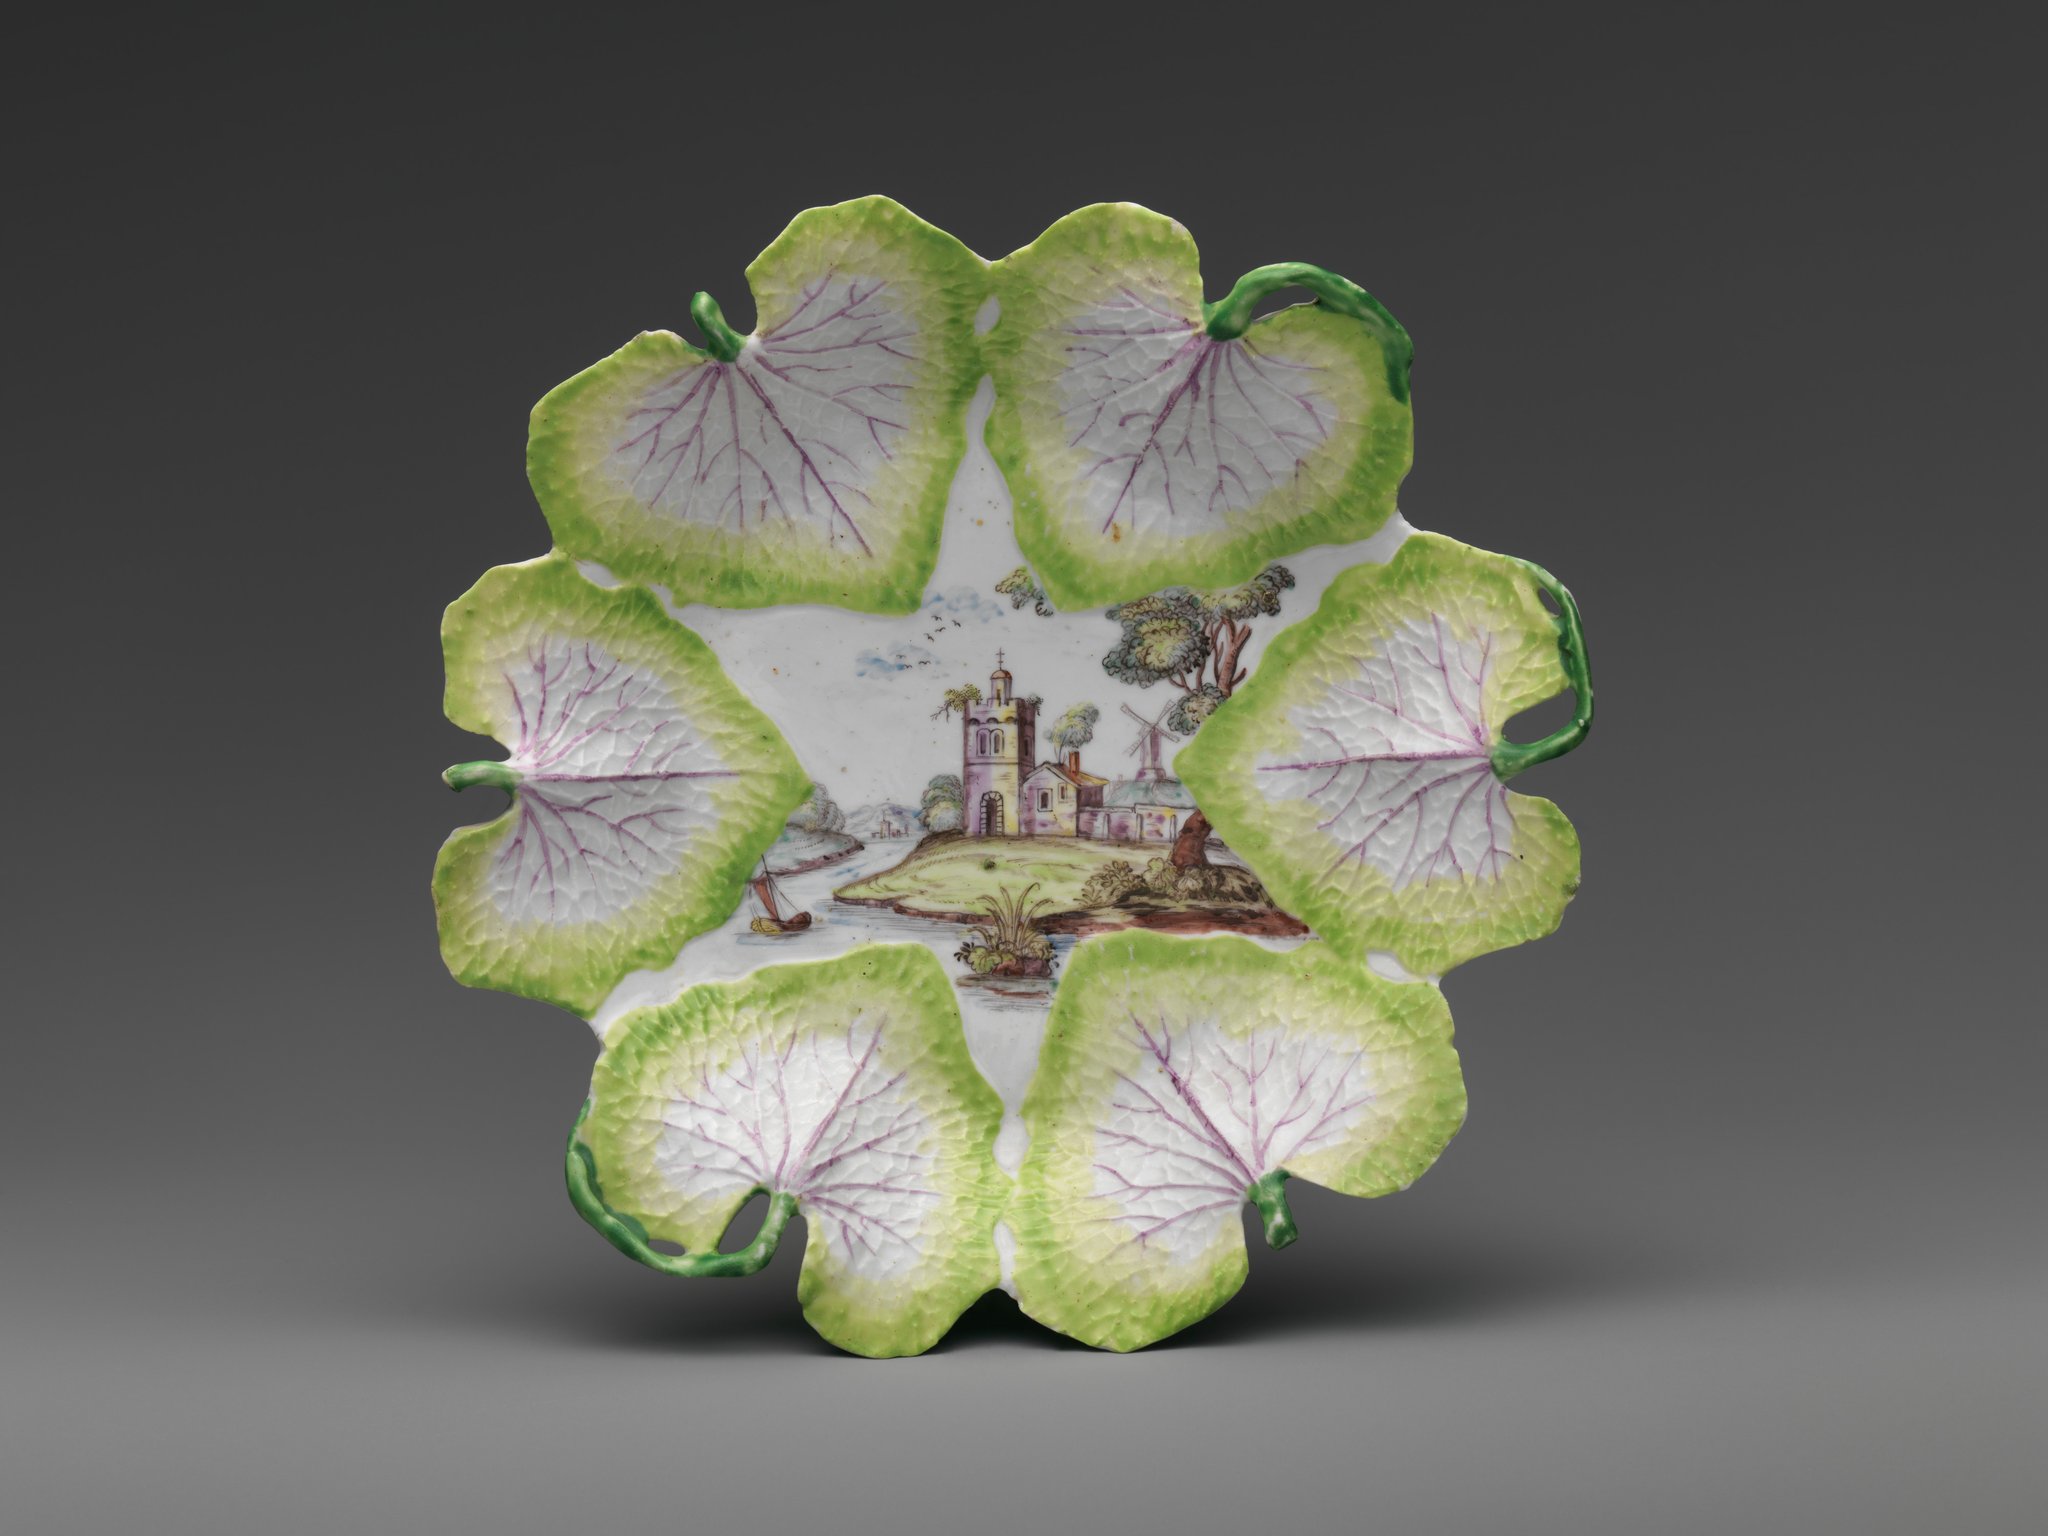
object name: dish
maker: longton hall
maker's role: factory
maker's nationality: british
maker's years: 1744-1760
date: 1749-1760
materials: enamel, soft paste porcelain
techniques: polychrome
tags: houses,leaves